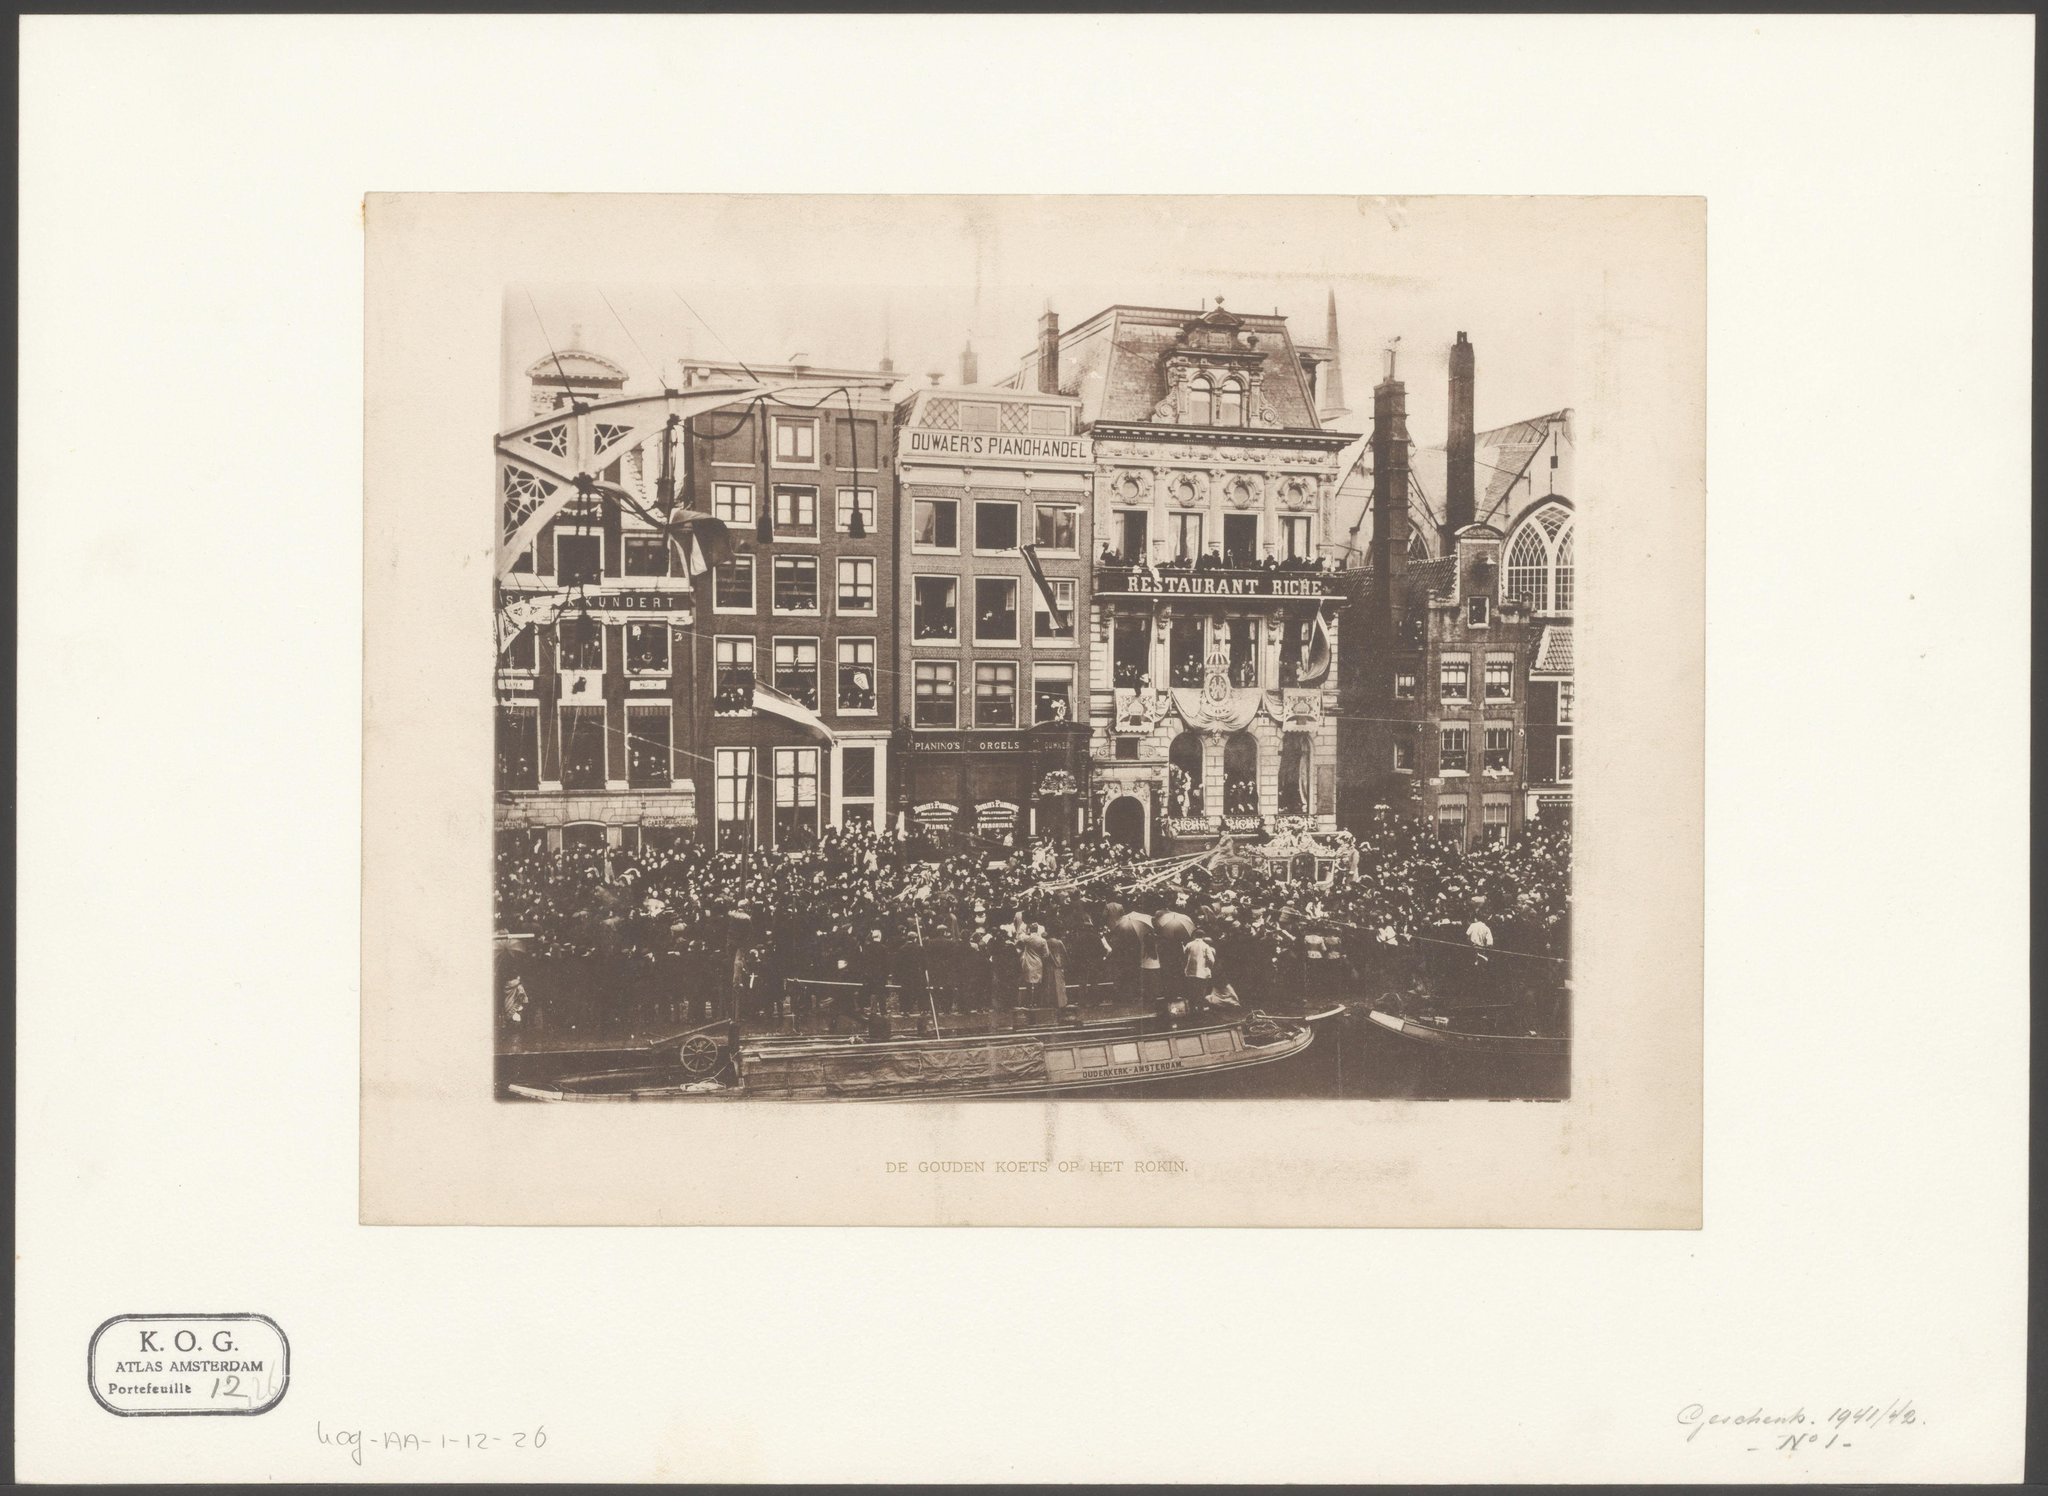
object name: photomechanical print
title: Gezicht op een optocht met de gouden koets op het Rokin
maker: Anonymous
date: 1901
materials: cardboard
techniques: photograph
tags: ruler and his subjects - bb - female ruler, city-view in general; 'veduta', wedding feast, wedding meal, street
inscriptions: collector's mark: ‘12,26’ Lugt 1641b, inscription: ‘Geschenk. 1941/42. / -No 1-’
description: Onderwerpsrubriek binnen de Atlas Amsterdam: Rokin, Rotterdammersloot, Rozengang, Rozengracht, Rozenstraat, Rusland, Rustenburgerstraat, Ruysdaelkade, Ruysdaelstraat, Ruyterkade (de), Ruyterweg (Admiraal de).